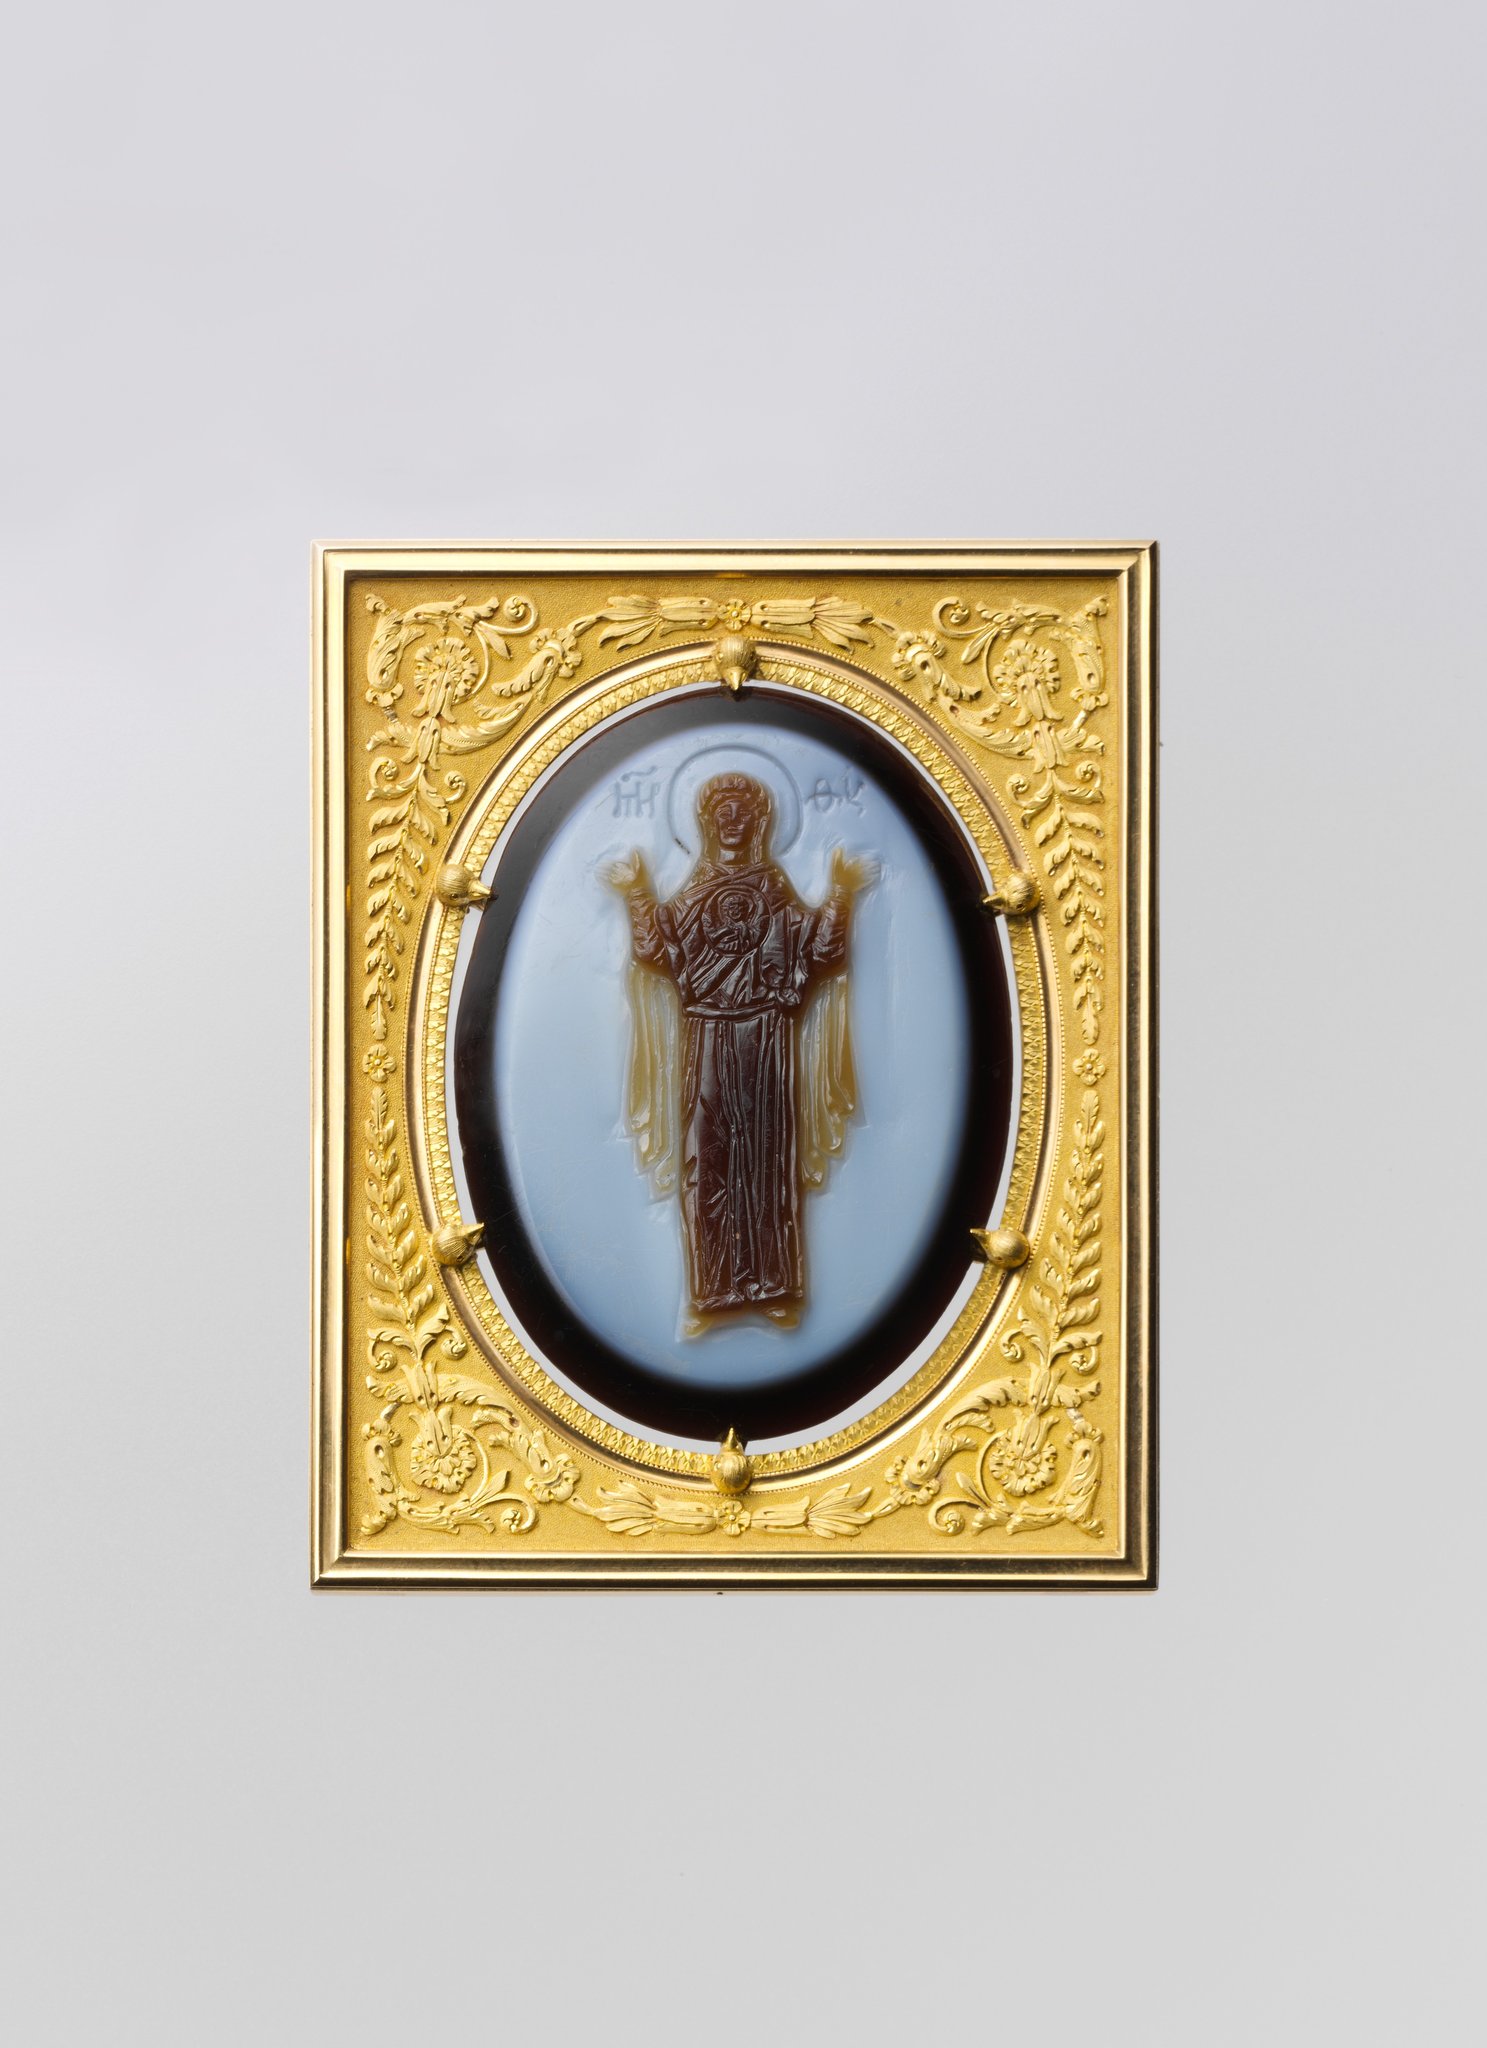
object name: cameo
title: Cameo of the Virgin and Child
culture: byzantine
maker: adrien jean maximilien vachette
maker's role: artist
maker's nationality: french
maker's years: 1753-1839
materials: stone, gold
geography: probably constantinople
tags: virgin mary